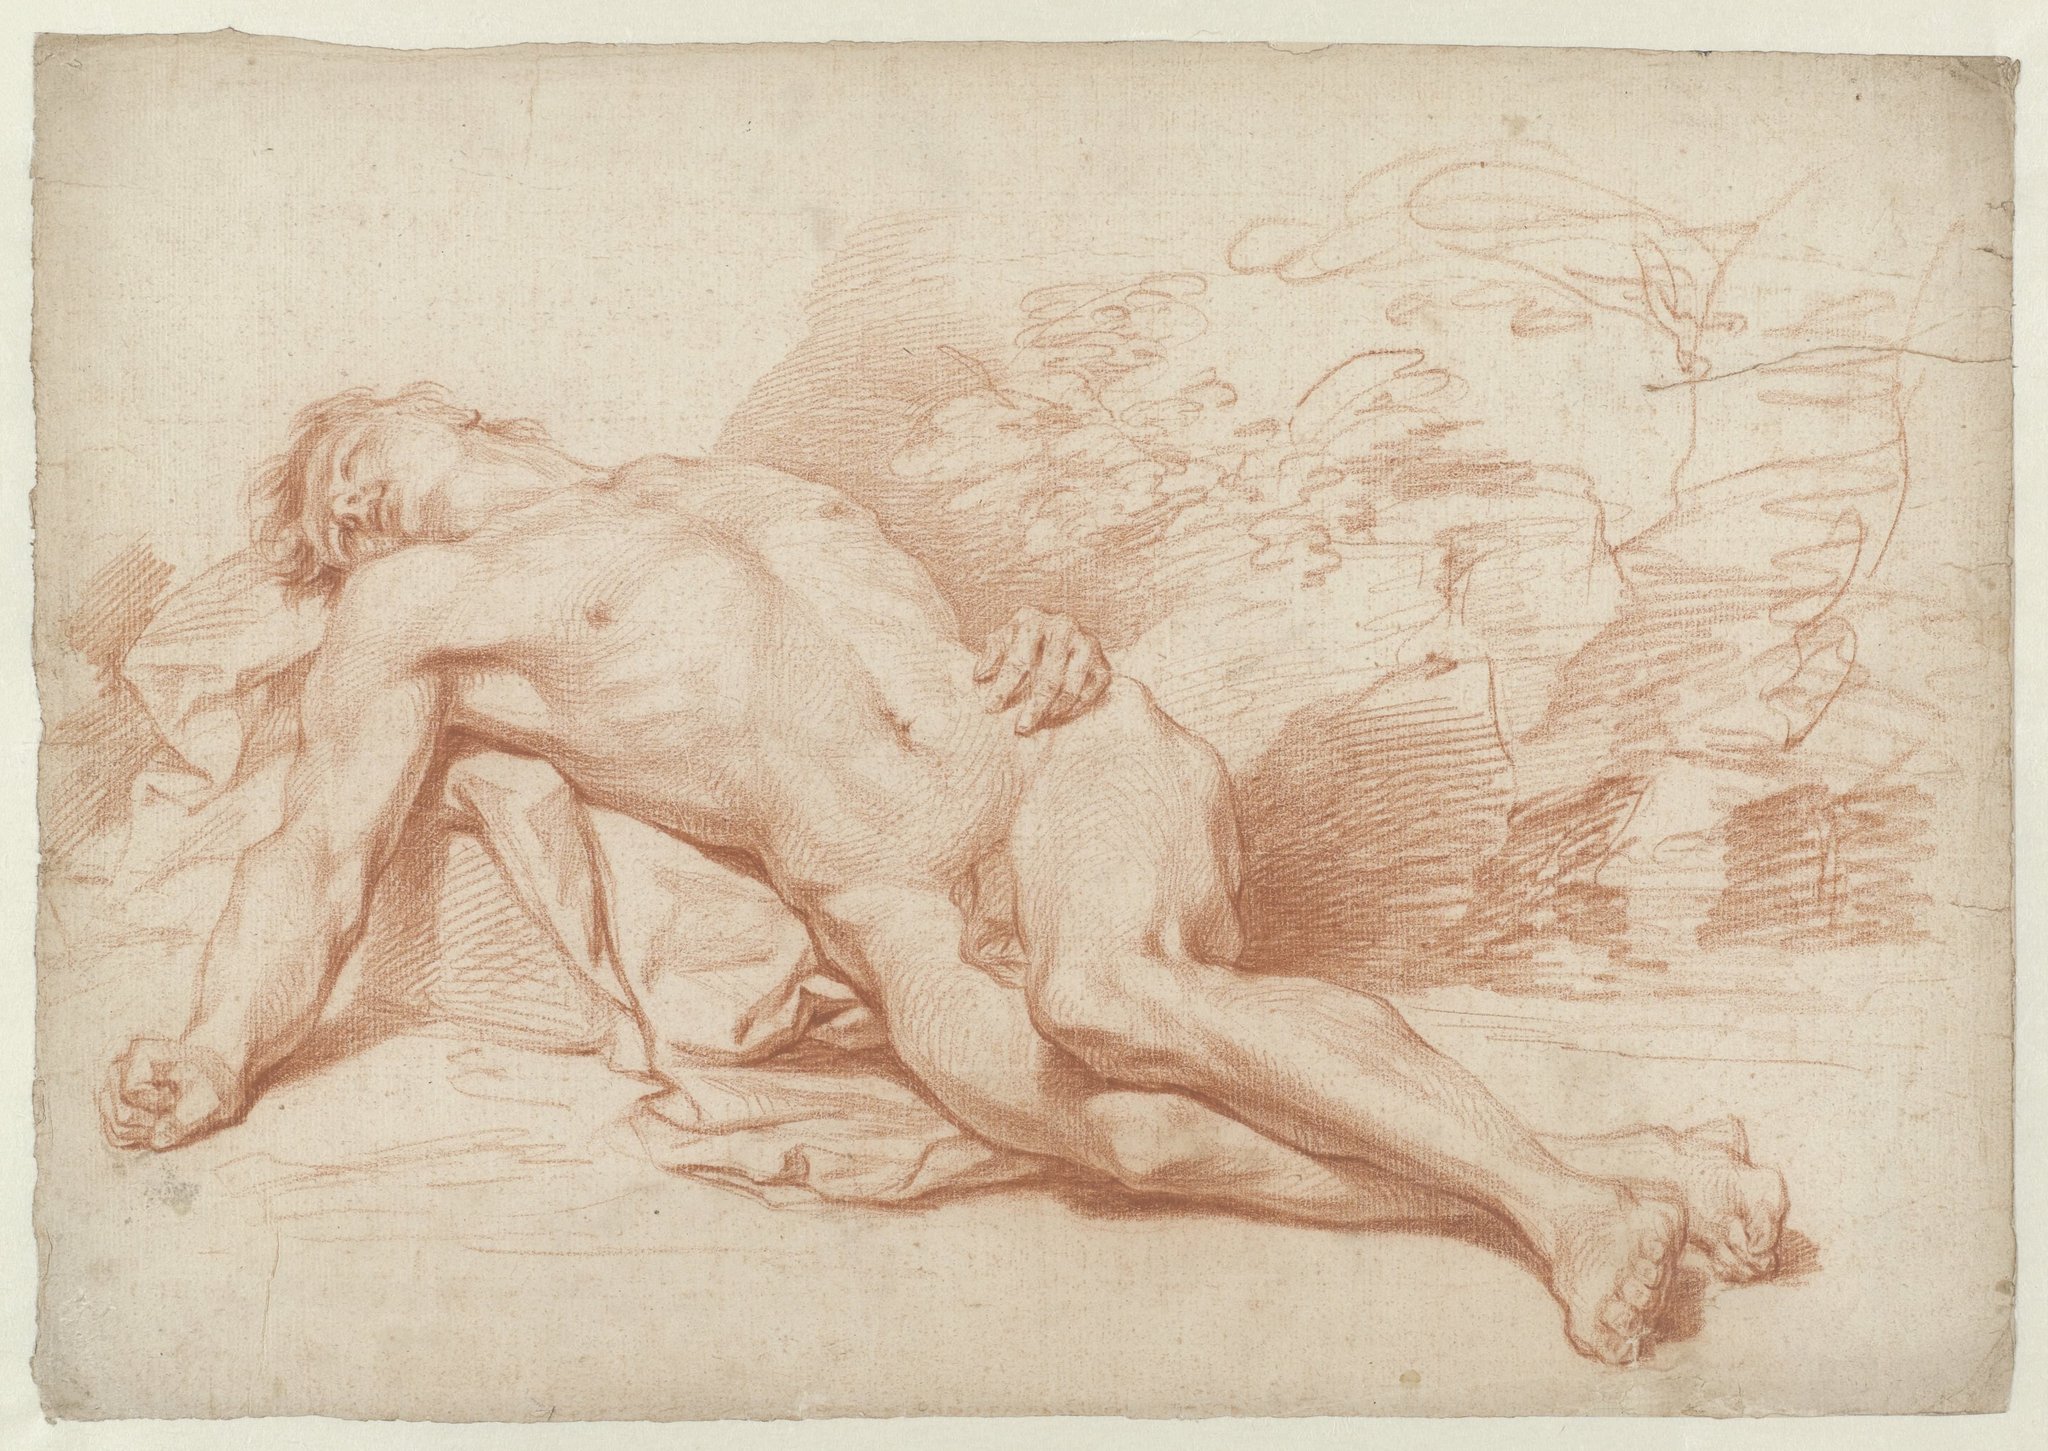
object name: drawing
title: Liggend mannelijk naakt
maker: cornelis joseph d heur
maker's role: draughtsman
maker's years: 1707-1762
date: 1717-1762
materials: chalk, paper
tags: lying figure